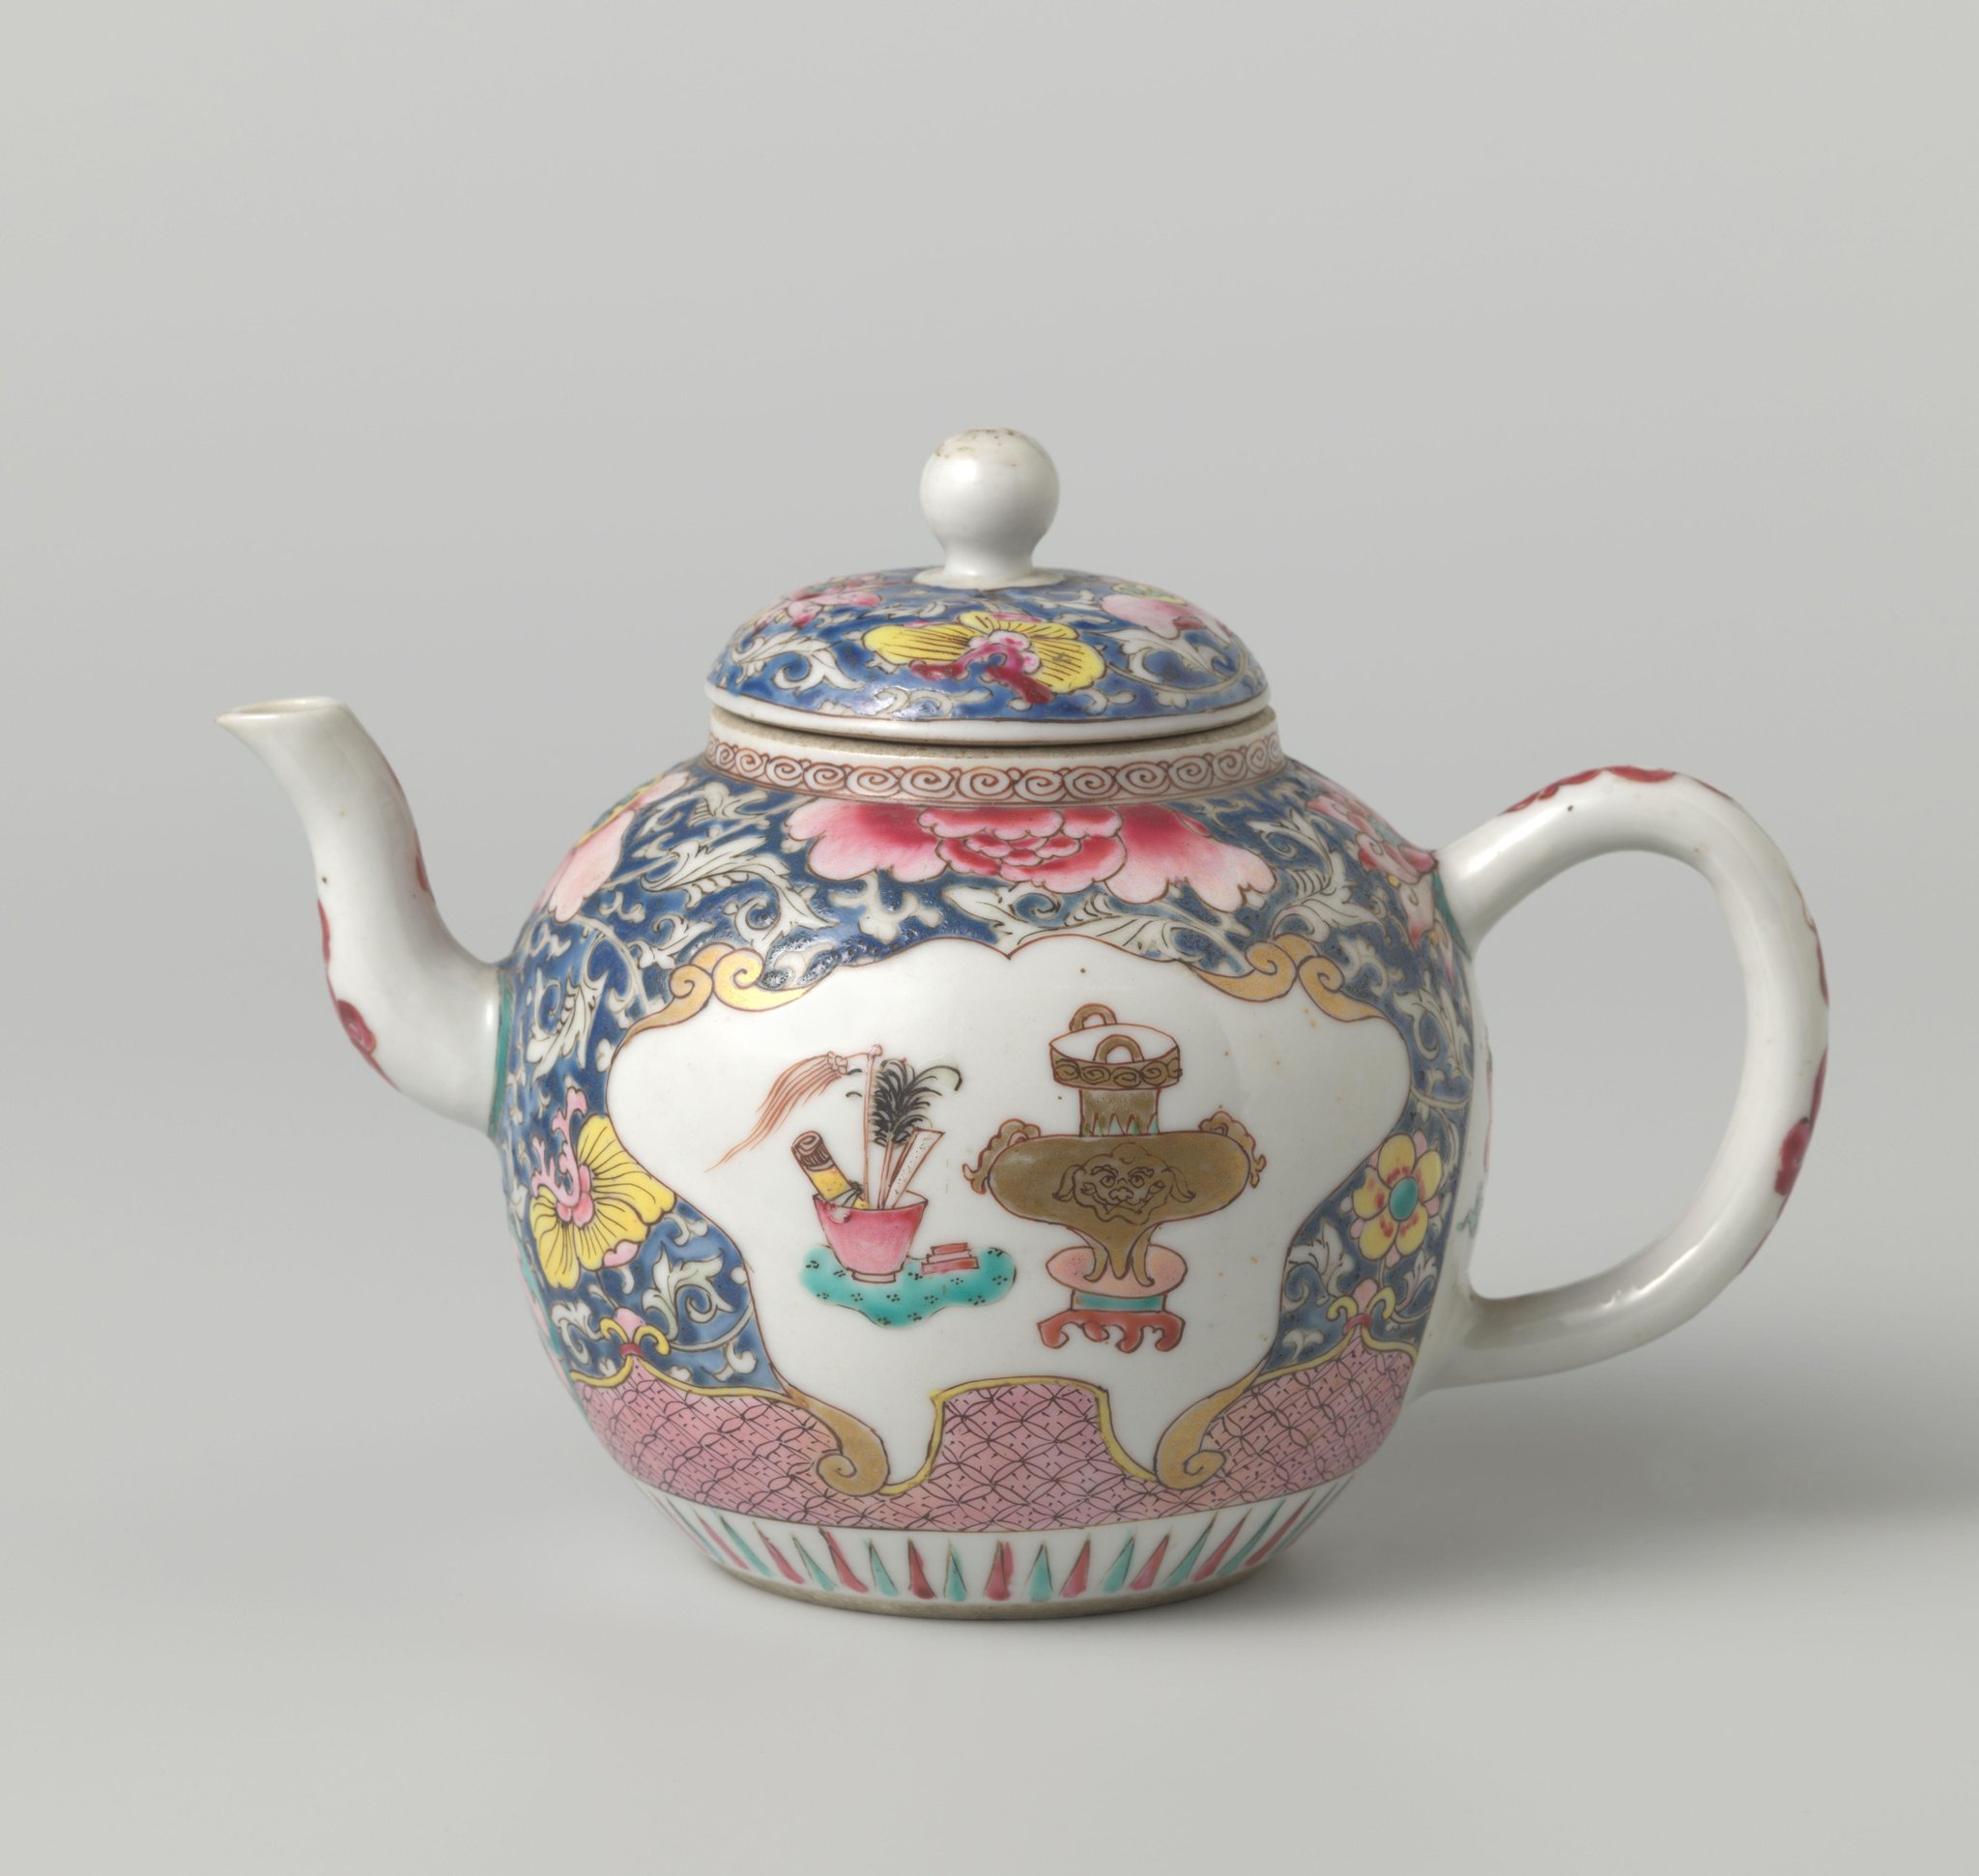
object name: lid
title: Teapot with flowers, floral scrolls and antiquities in panels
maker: Anonymous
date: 1800-1899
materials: glaze, gold, paint, porcelain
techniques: firing, gilding, turning, vitrification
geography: china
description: Deksel van theepot van porselein, beschilderd op het glazuur in blauw, rood, roze, geel, zwart en goud. Een band met puntige motieven, daarboven een band met servetwerk, uitgespaarde bloemranken in een blauwe grond met grote bloemen (o.a. pioen, lotus) afgebeeld. Famille rose.